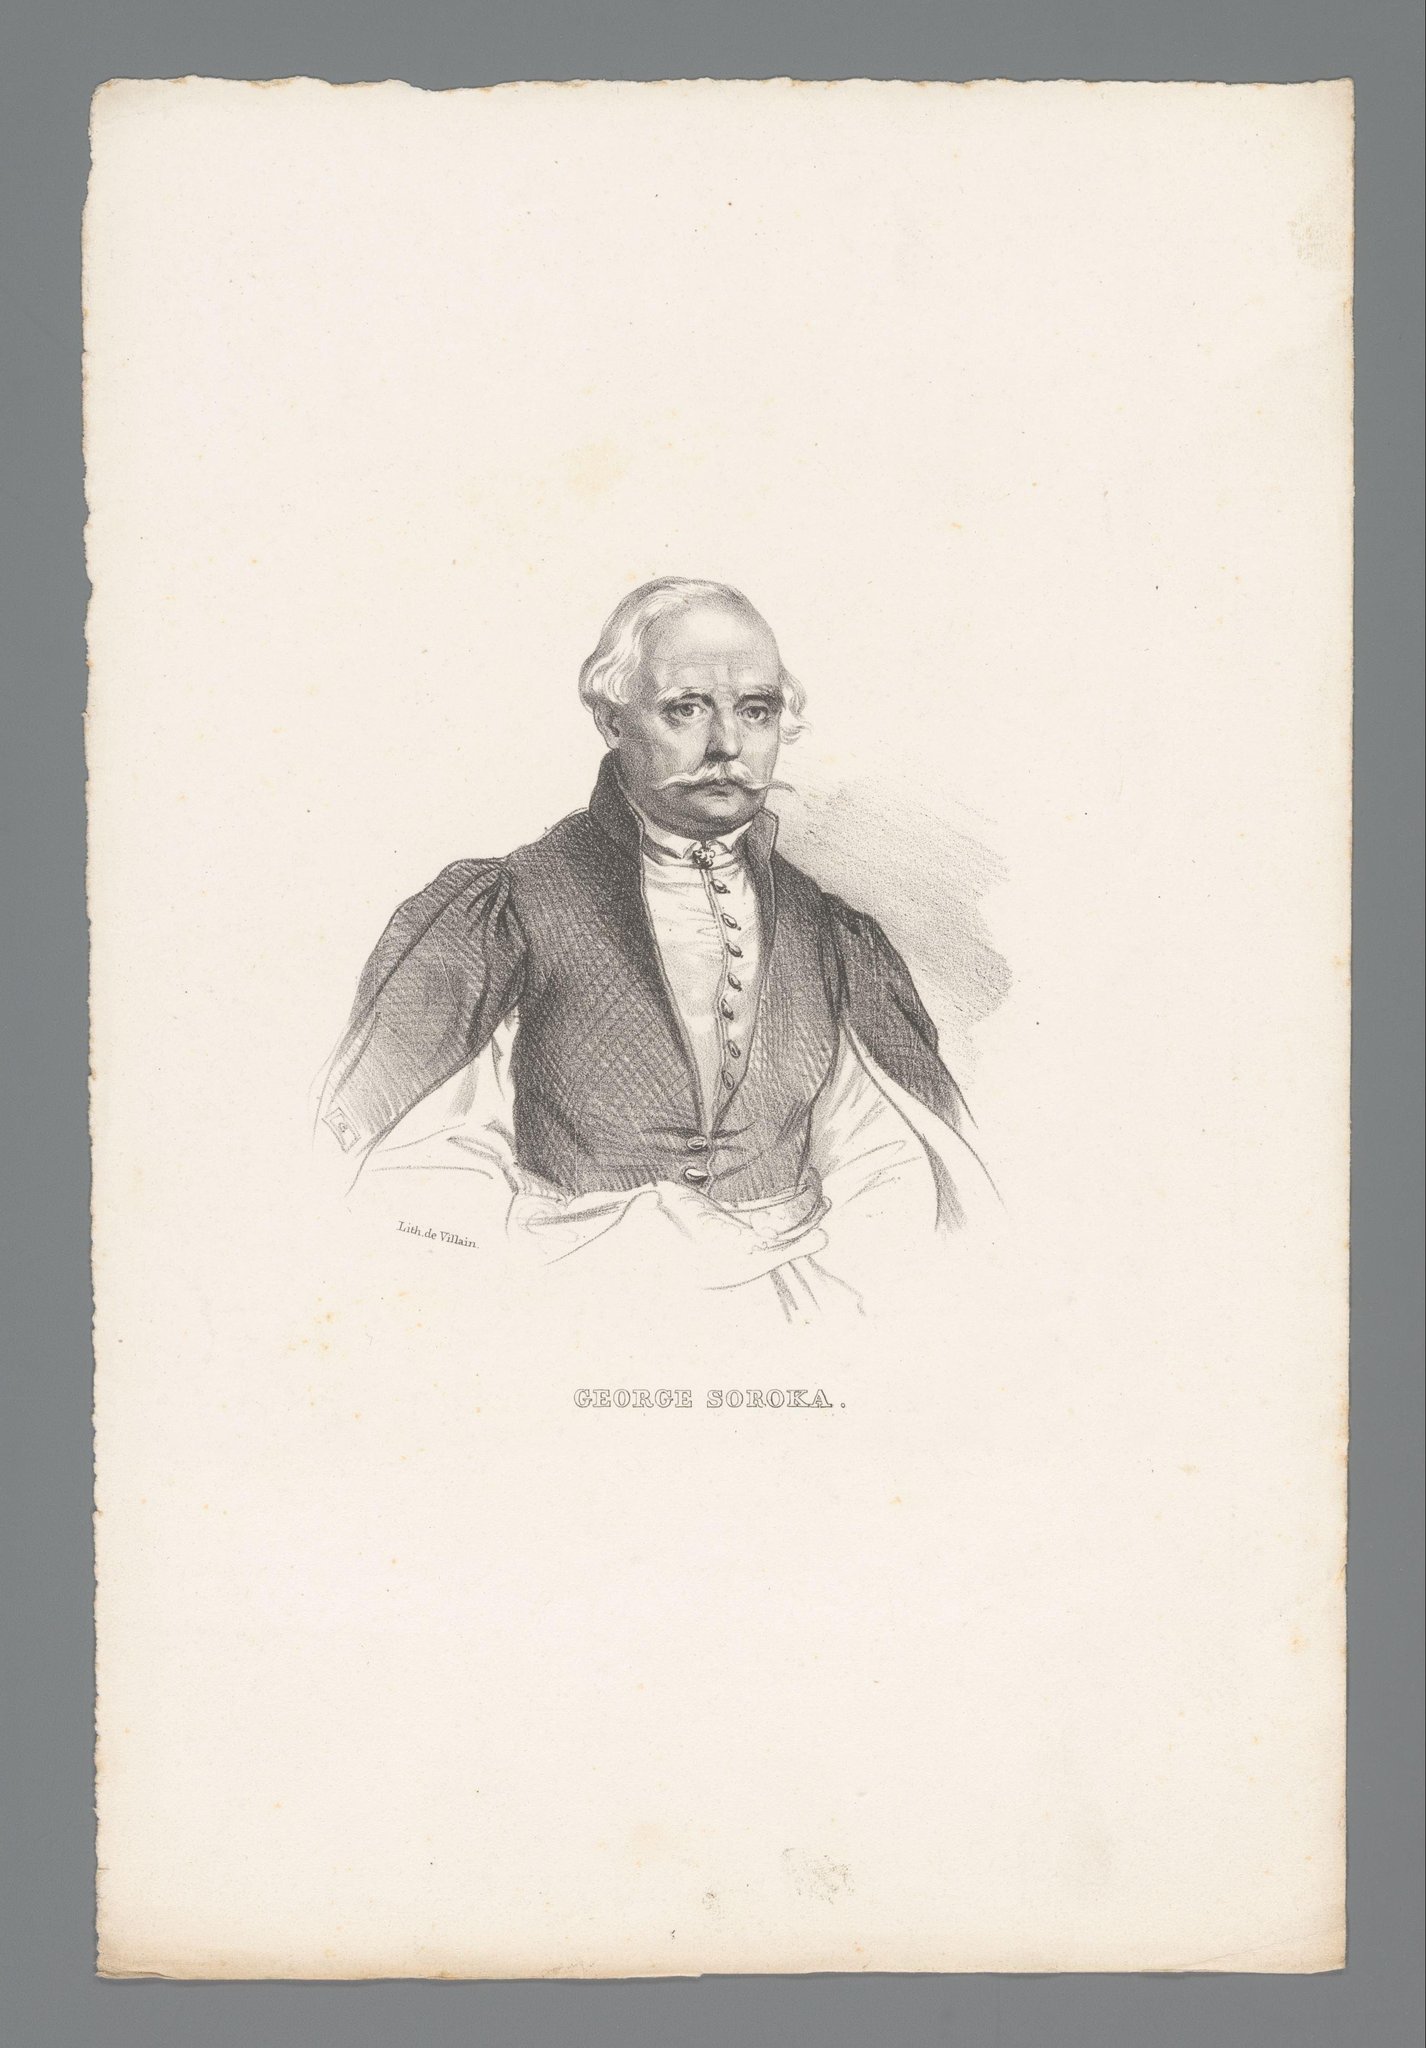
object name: book illustration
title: Portret van Jerzy Soroka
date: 1832-1839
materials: paper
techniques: lithograph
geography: paris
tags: historical persons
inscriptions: collector's mark: Lugt 2228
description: Prent uit: Straszewicz., Joseph. Les polonais et les polonaises de la révolution du 29 novembre 1830, ou Portraits des personnes qui ont figuré dans la dernière guerre de l'indépendance polonaise, avec les fac-simile de leur signature, lithographiés sur dessins originaux, par les artistes les plus distingués: MM. Grévedon, Maurin, Vigneron, Belliard, Devéria, Bazin, Desmadryl, Lecler, Desmaisons, Rutowski, officier polonais, etc,. etc., accompagnés d'une biographie pour chaque portrait. Parijs: Catherine-Anaïs Pinard, 1832. Of uit: Straszewicz., Joseph. Les polonais et les polonaises de la révolution du 29 novembre 1830. Biographie des personnes qui ont figuré dans la dernière guerre de l'indépendance polonaise, avec les fac-simile de leur signature, ornée de 30 portraits lithographiés sur dessins originaux, par les artistes les plus distingués: MM. Grévedon, Maurin, Vigneron, Belliard, Devéria, Bazin, Desmadryl, Lecler, etc., etc.. Parijs: s.n., 1839.